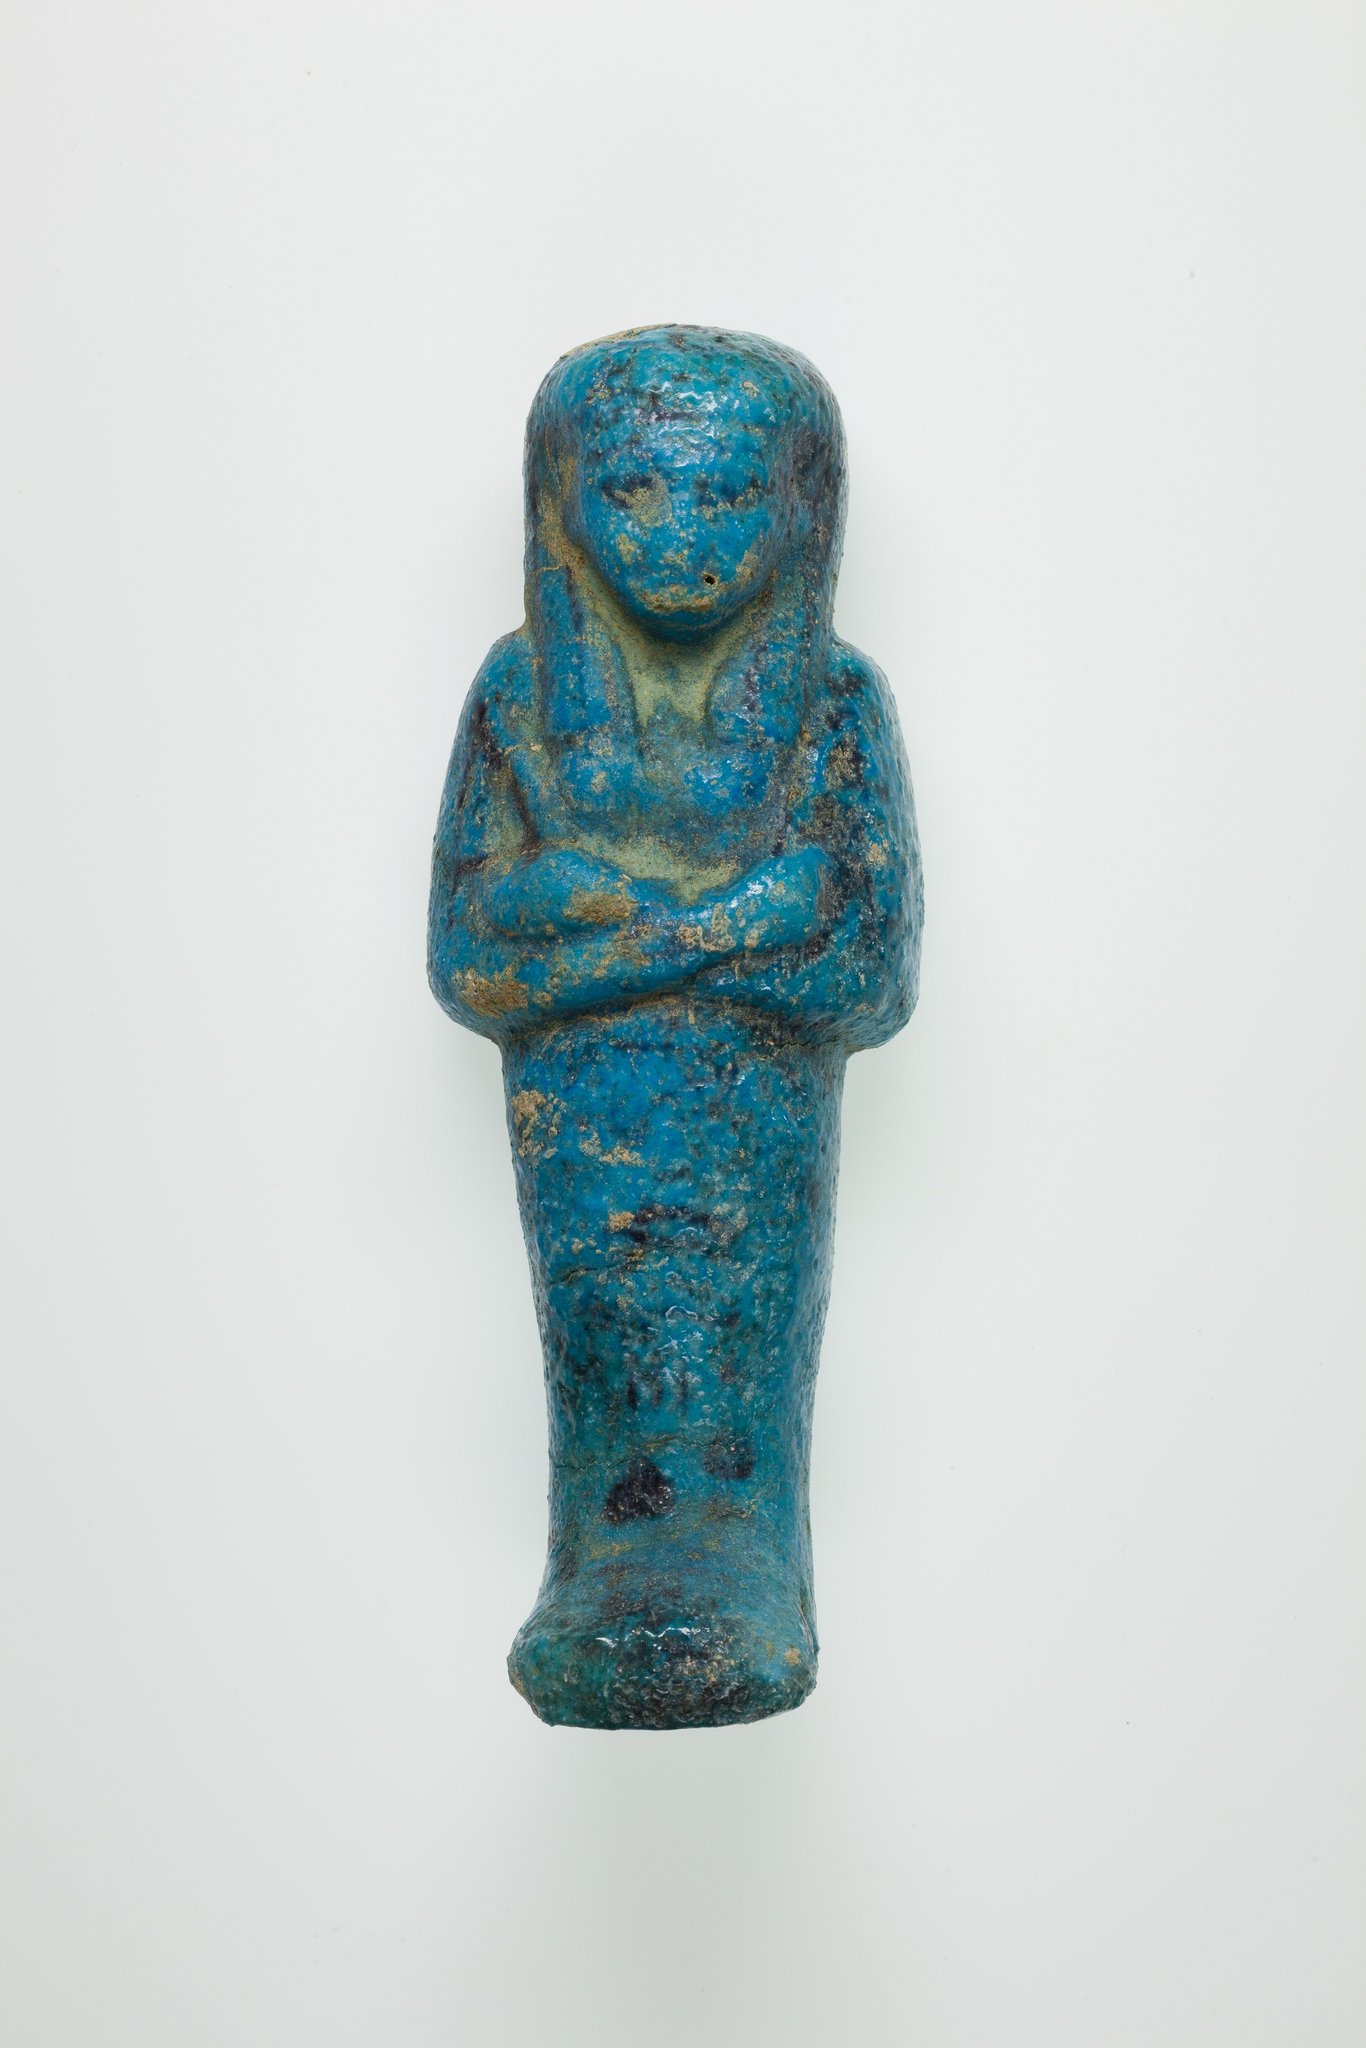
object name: shabti, henettawy c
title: Worker Shabti of Henettawy (C), Daughter of Isetemkheb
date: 990-970 BCE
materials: faience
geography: egypt